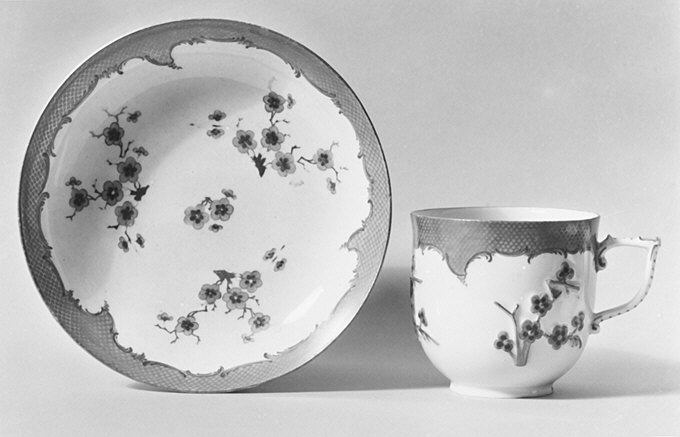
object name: cup and saucer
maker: meissen manufactory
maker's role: manufactory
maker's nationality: german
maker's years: 1710-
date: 1765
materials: hard paste porcelain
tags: flowers